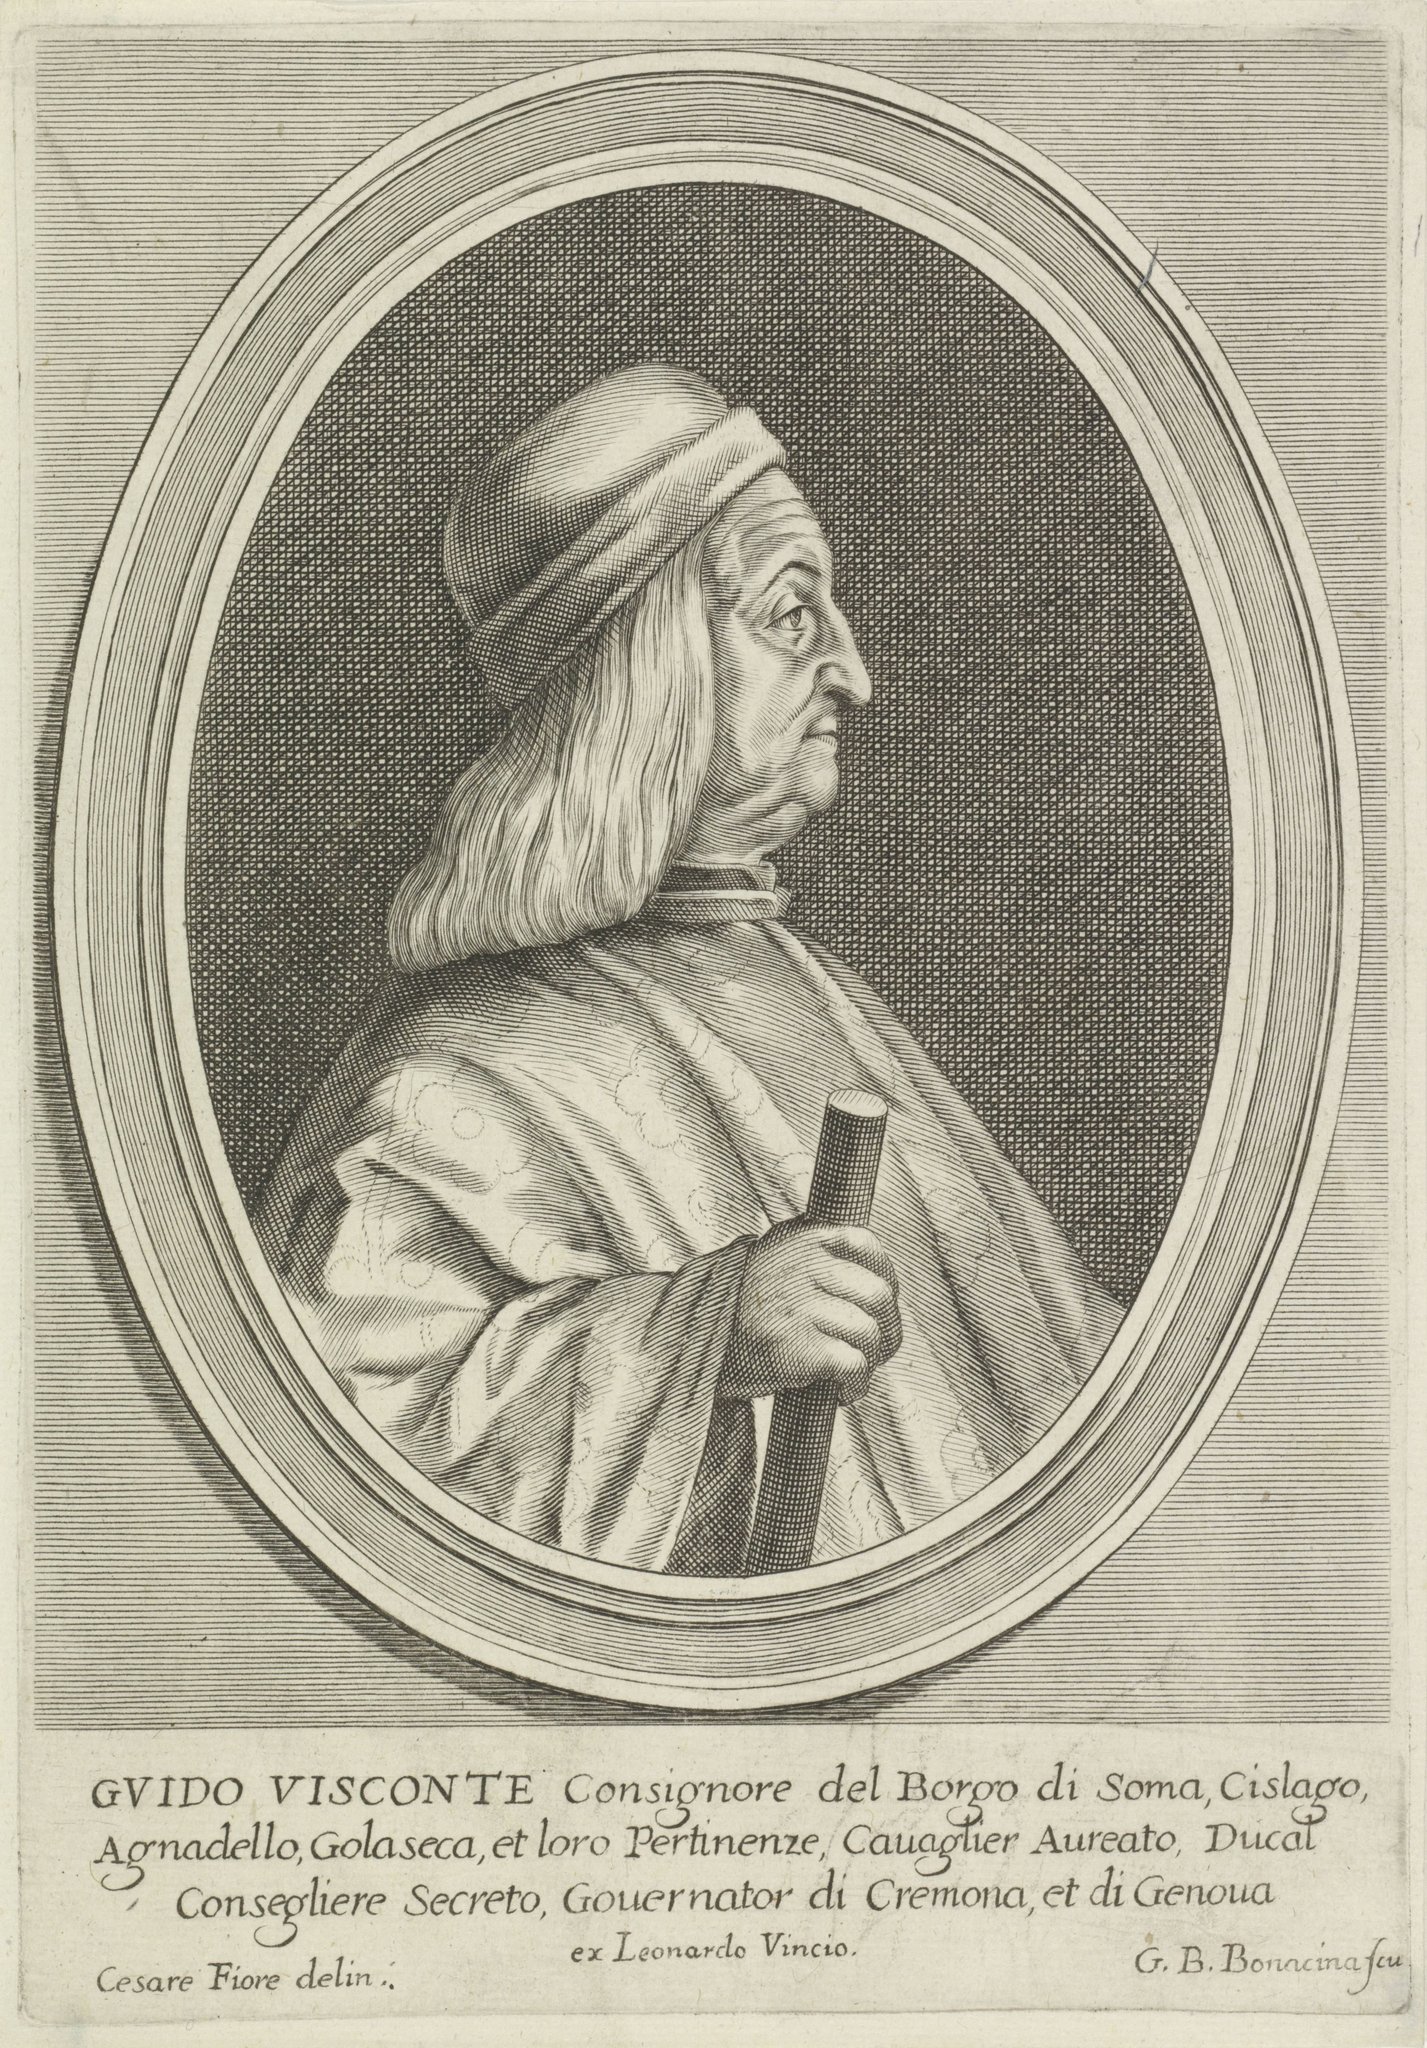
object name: print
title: Portret van Guido Visconti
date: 1625-1669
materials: paper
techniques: engraving, etching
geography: italy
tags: historical persons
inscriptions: collector's mark: Lugt 2228